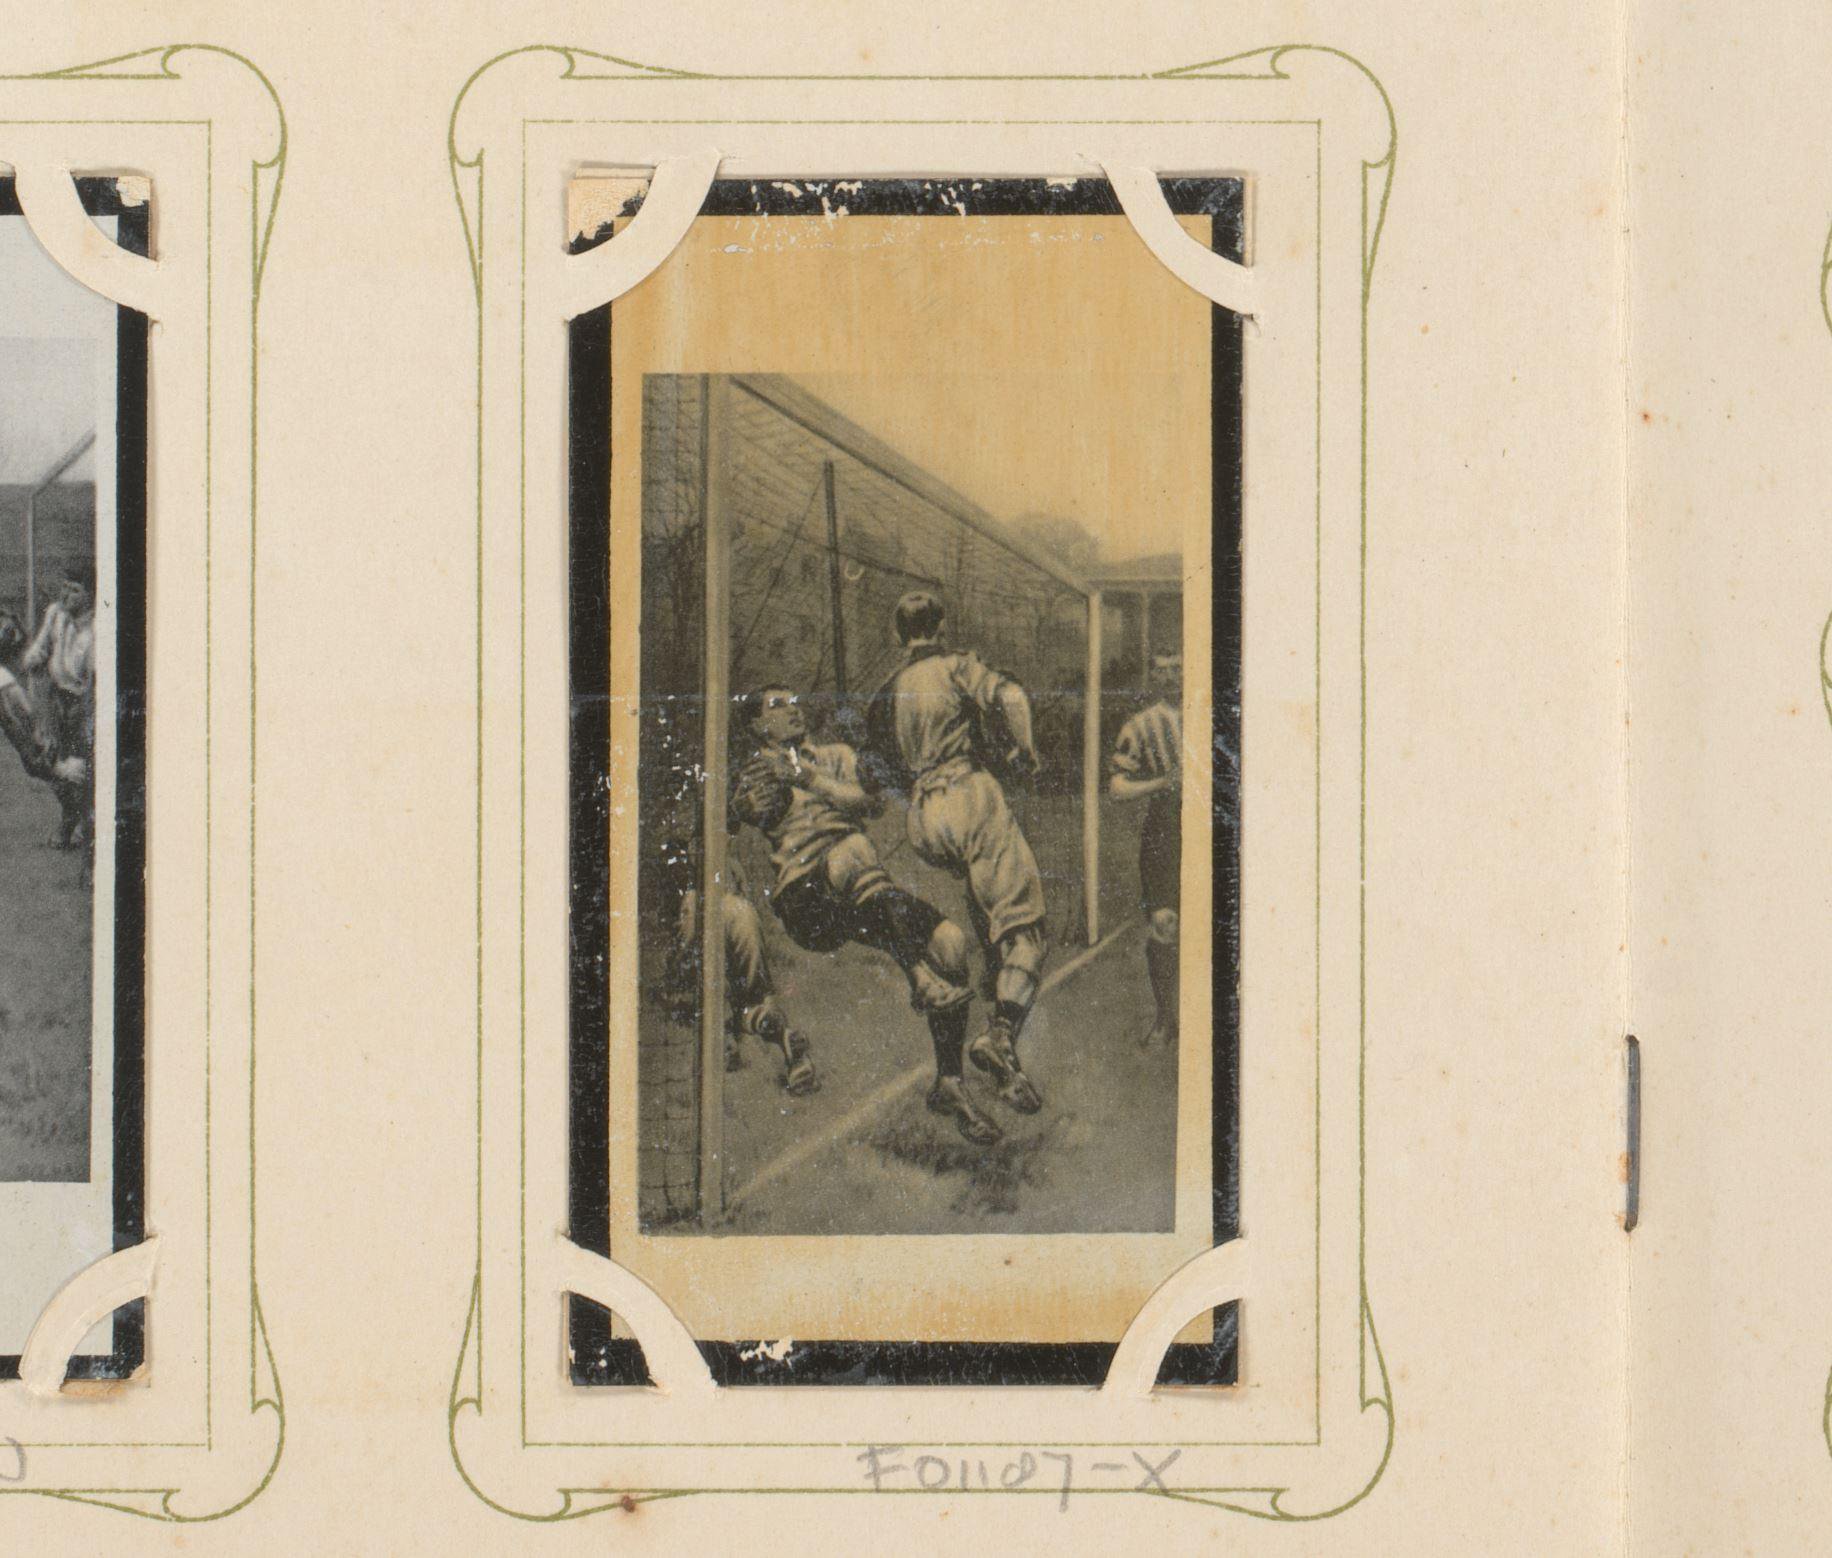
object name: photomechanical print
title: Reproductie van een tekening van de keeper die een schot stopt tijdens een voetbalwedstrijd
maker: Anonymous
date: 1905-1906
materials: paper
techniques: photograph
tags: adult man (+ two persons), soccer, football (early names: soule, choule, cholle) (+ the contest (sports, games, etc.))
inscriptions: inscription: ‘No. 6./ De overwinning.’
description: Deze prent maakt deel uit van een album.